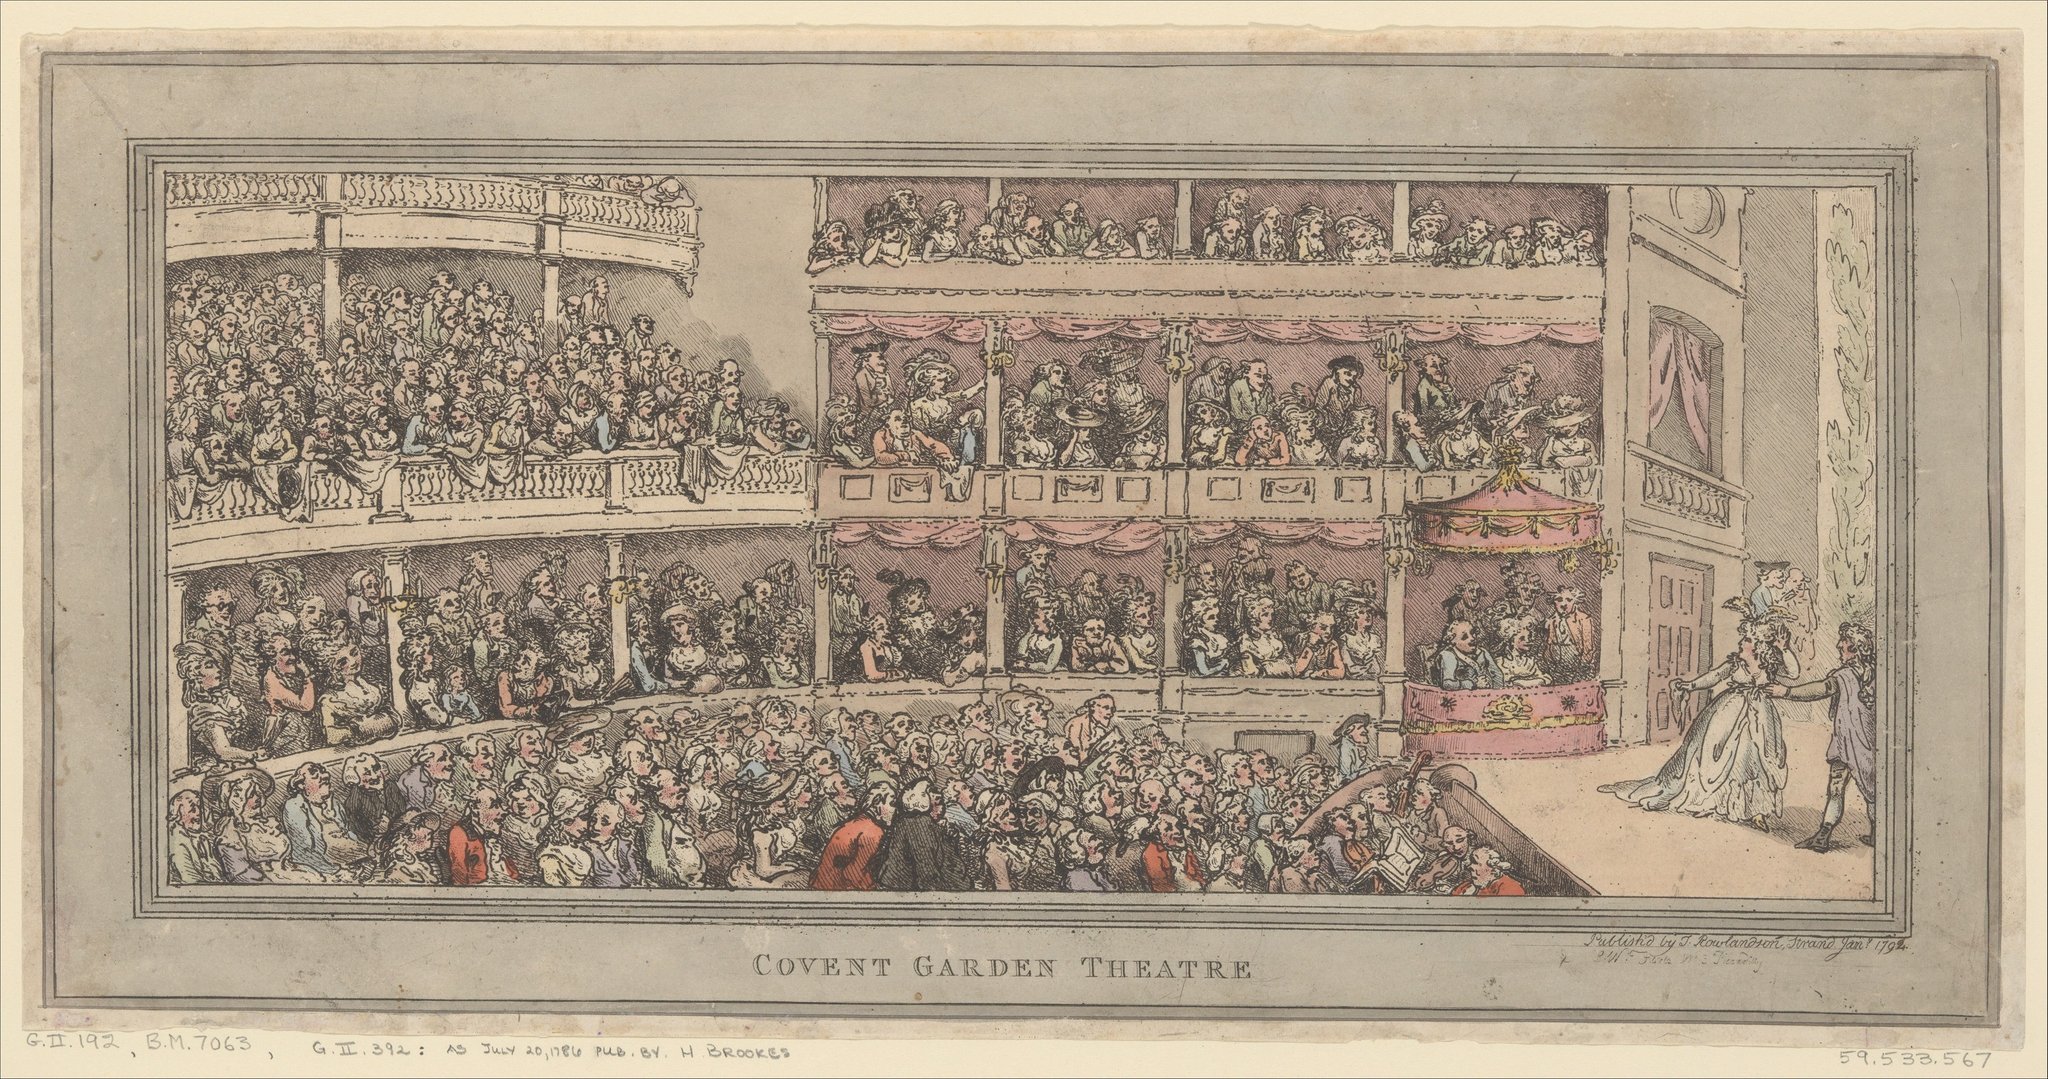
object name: print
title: Covent Garden Theatre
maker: thomas rowlandson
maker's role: artist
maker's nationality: british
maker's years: 1757-1827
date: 1792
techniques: aquatint, etching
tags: theatre,men,women,crowd